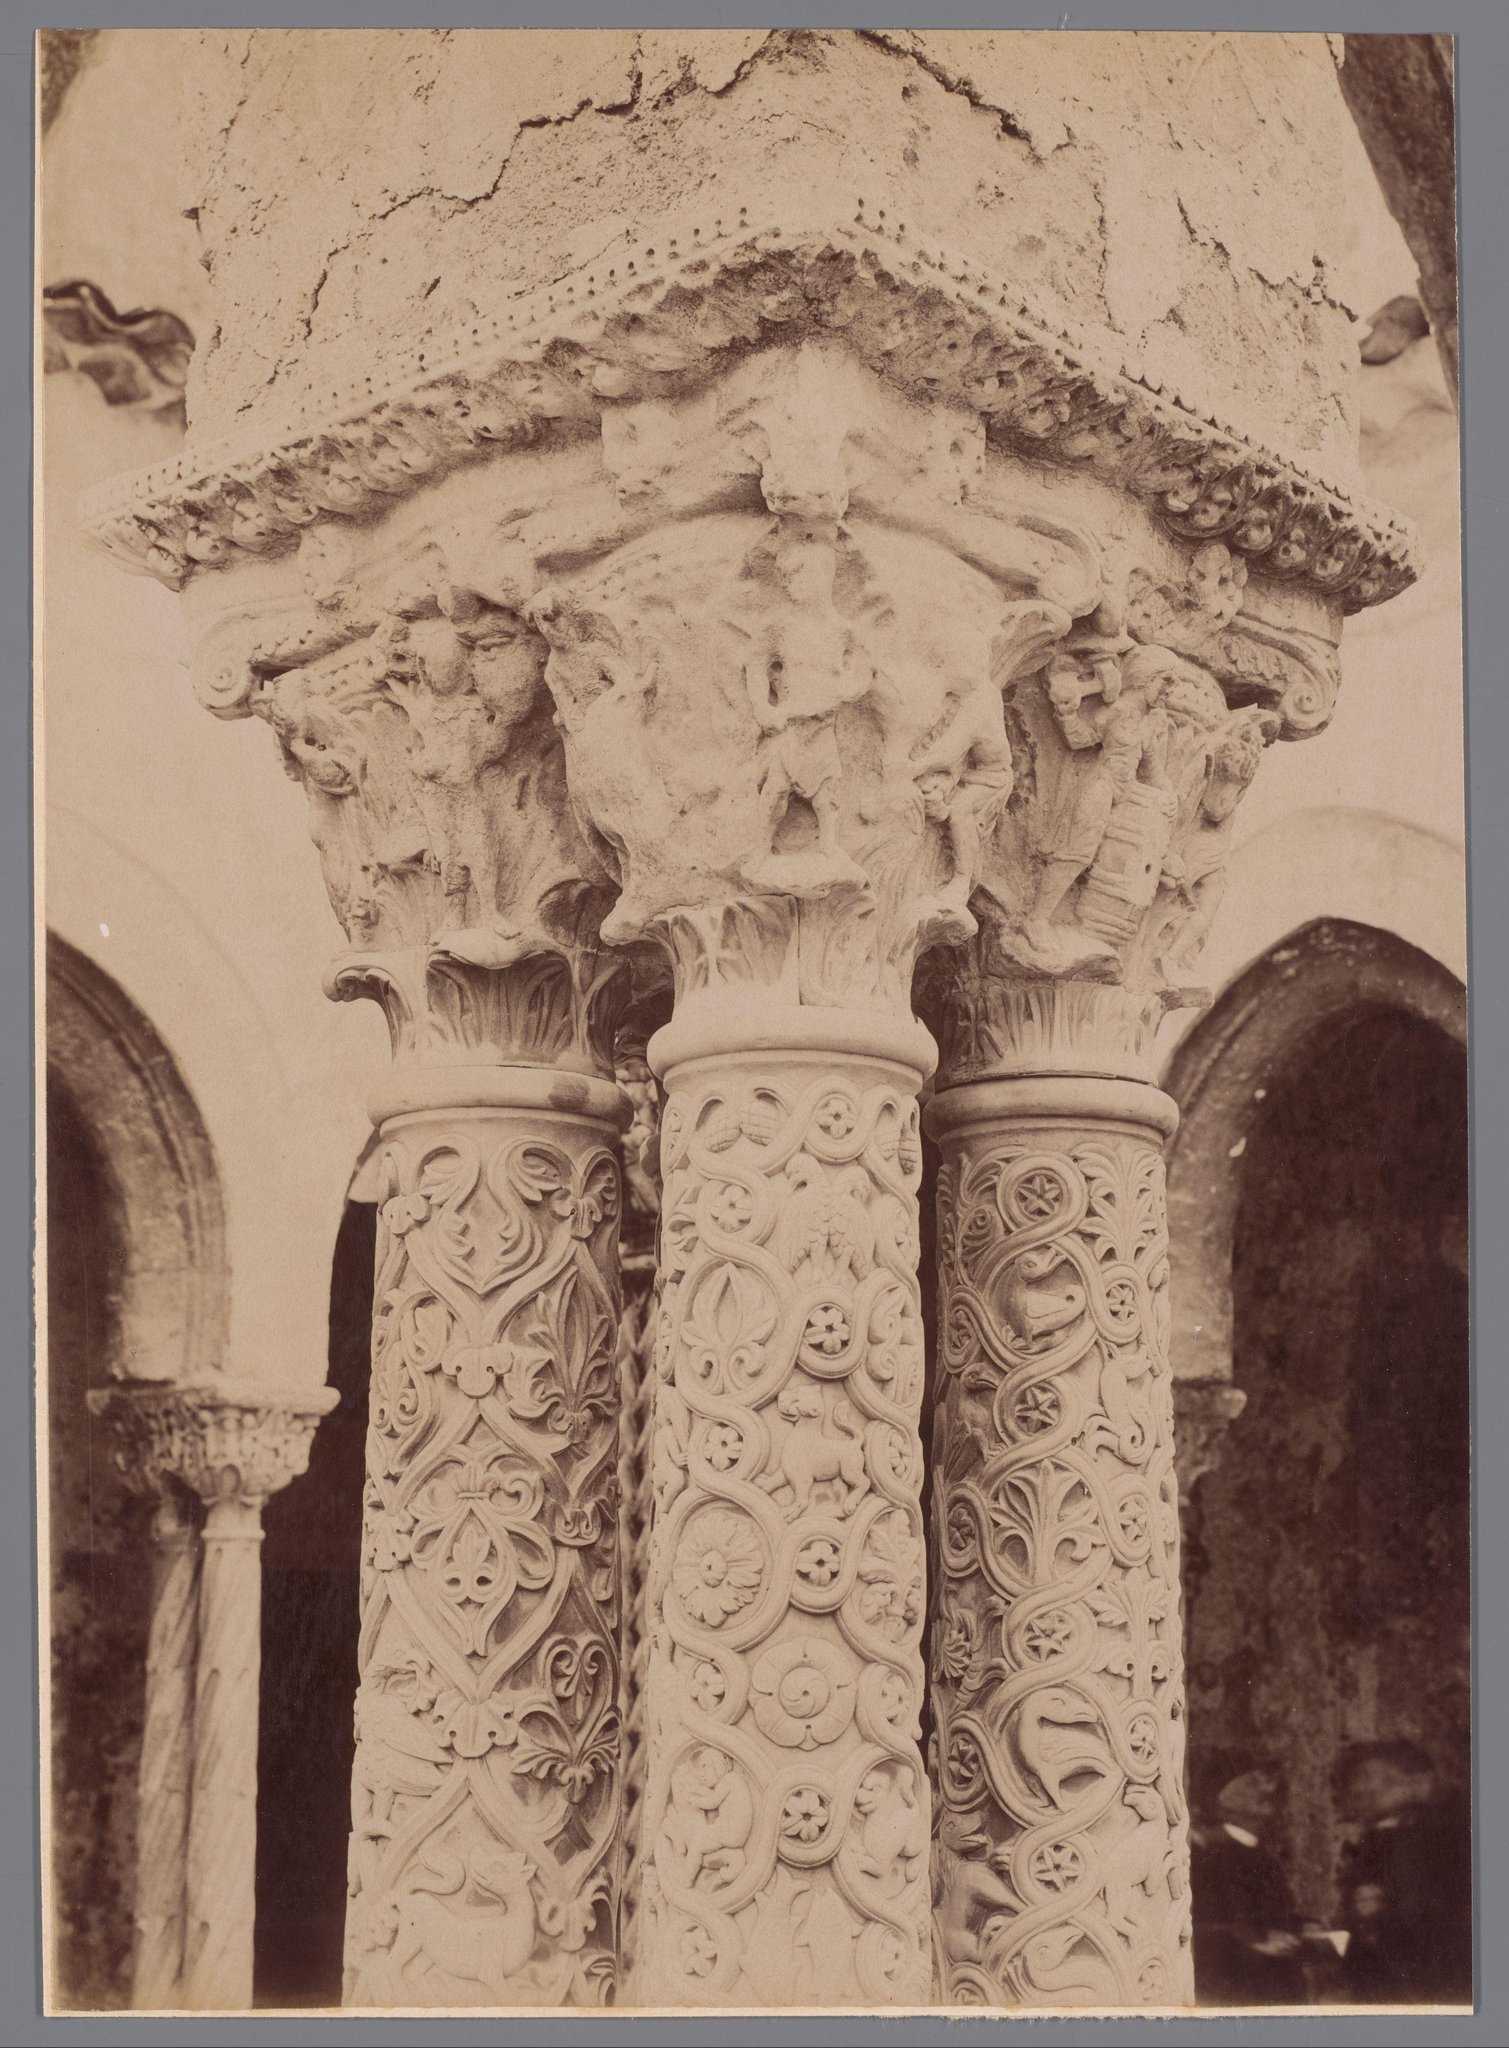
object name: photograph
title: Detailopname van een kapiteel in de kloostergang van de dom van Monreale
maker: giuseppe incorpora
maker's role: fotograaf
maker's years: 1834-1914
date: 1856-1914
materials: cardboard, paper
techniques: albumen print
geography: monreale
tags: abbey, monastery, convent ~ roman catholic church